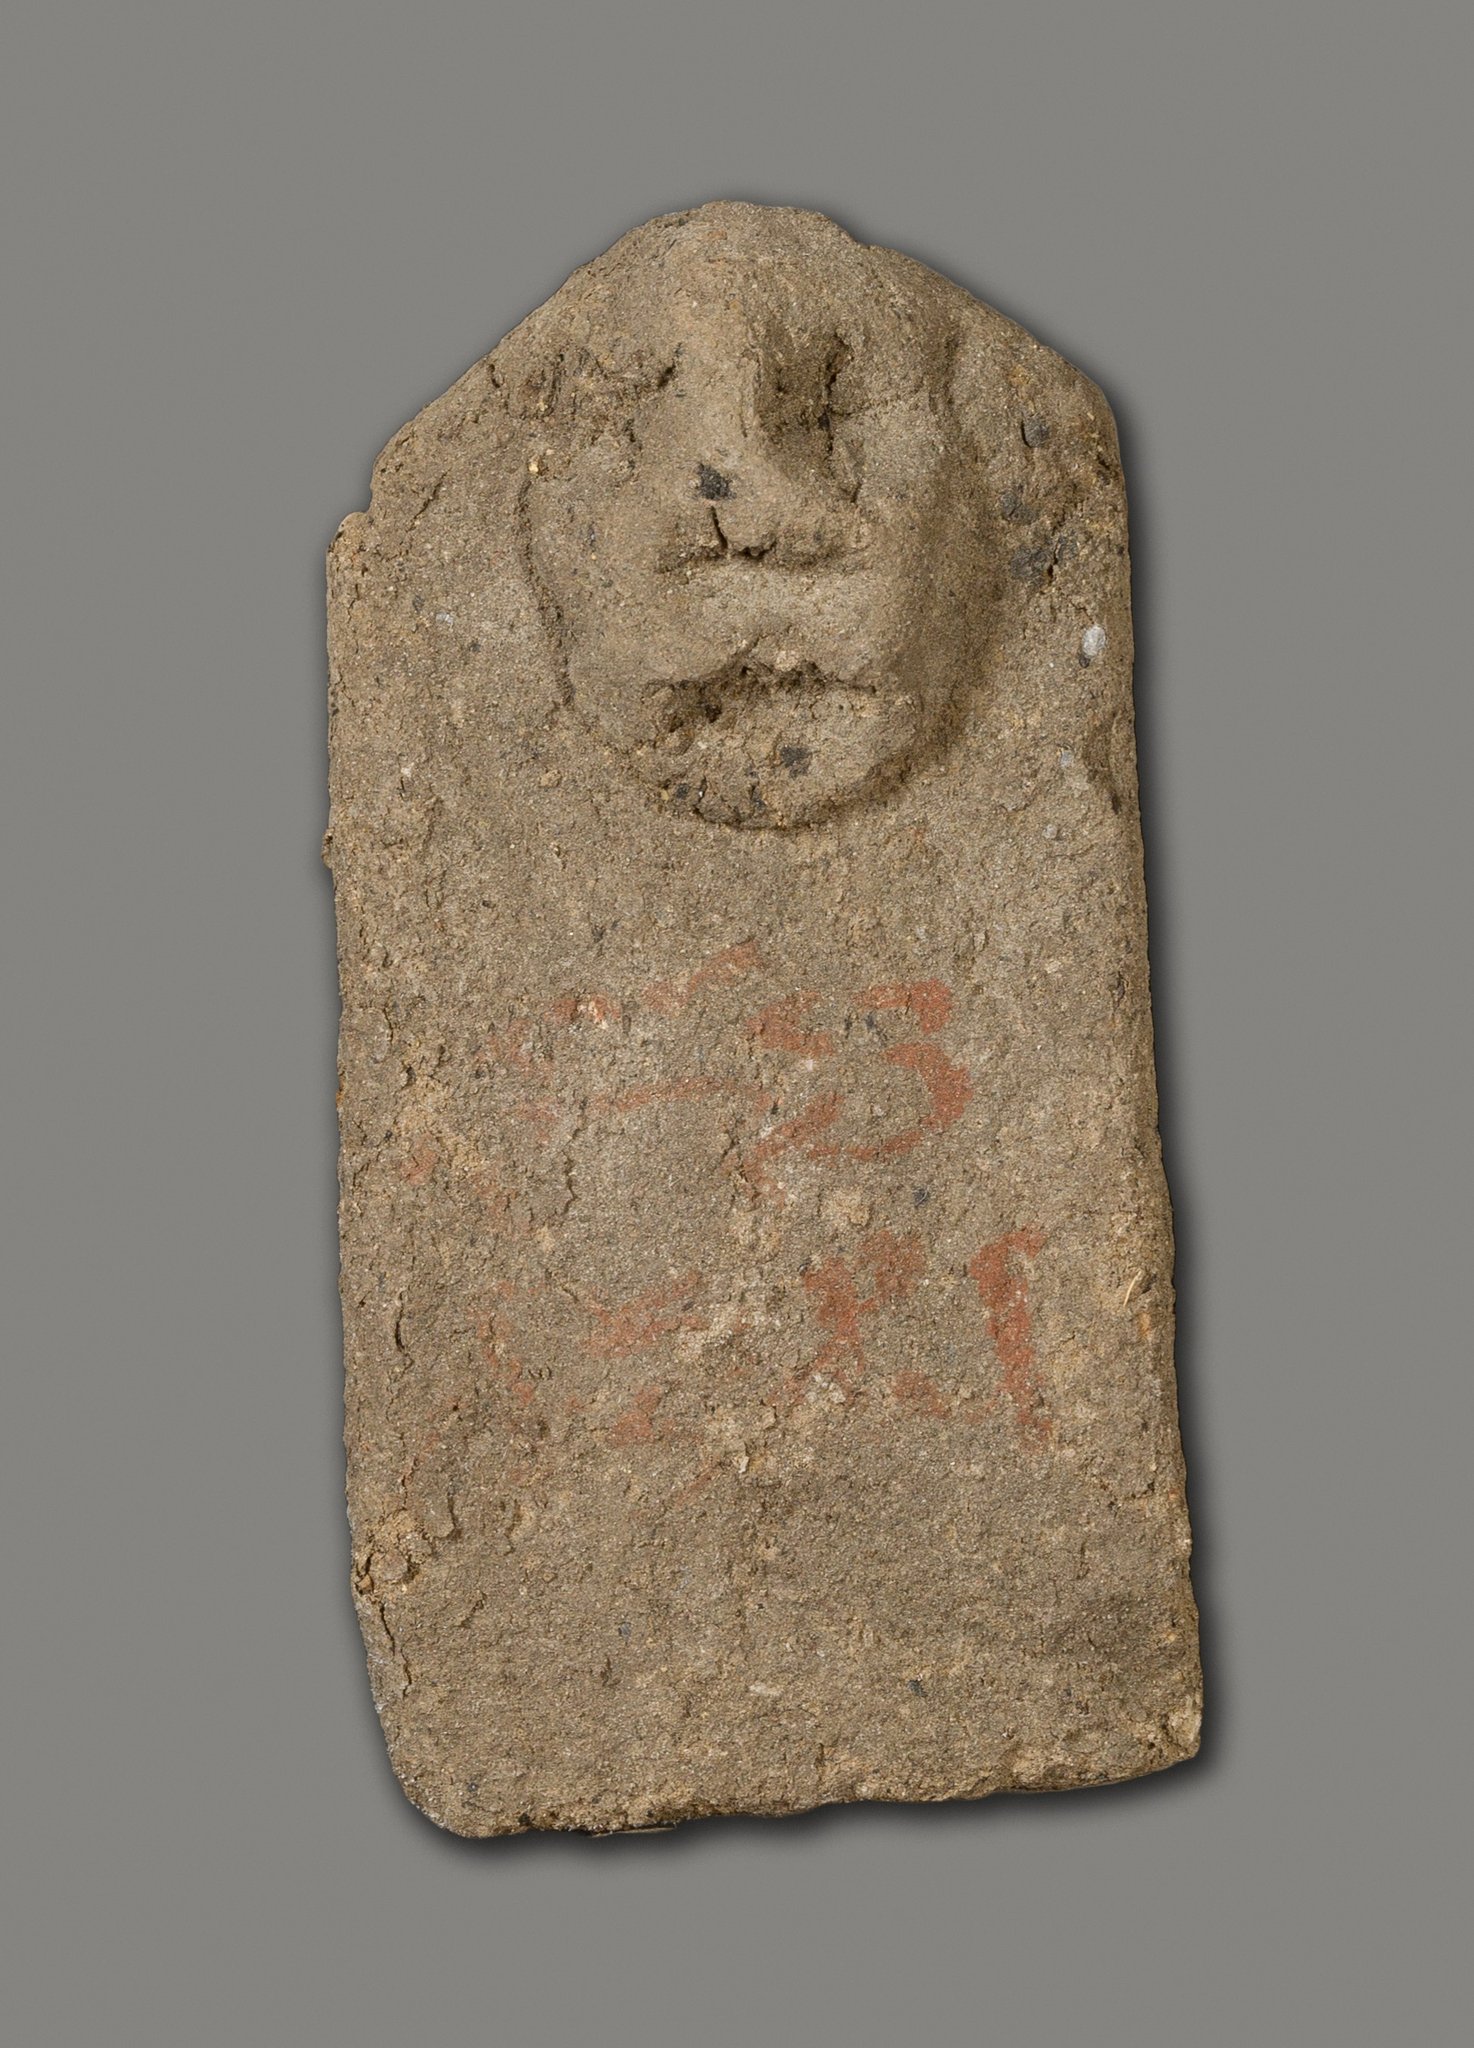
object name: figure, magical, execration, tablet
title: Magical Figure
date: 1802-1550 BCE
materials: clay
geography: egypt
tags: faces